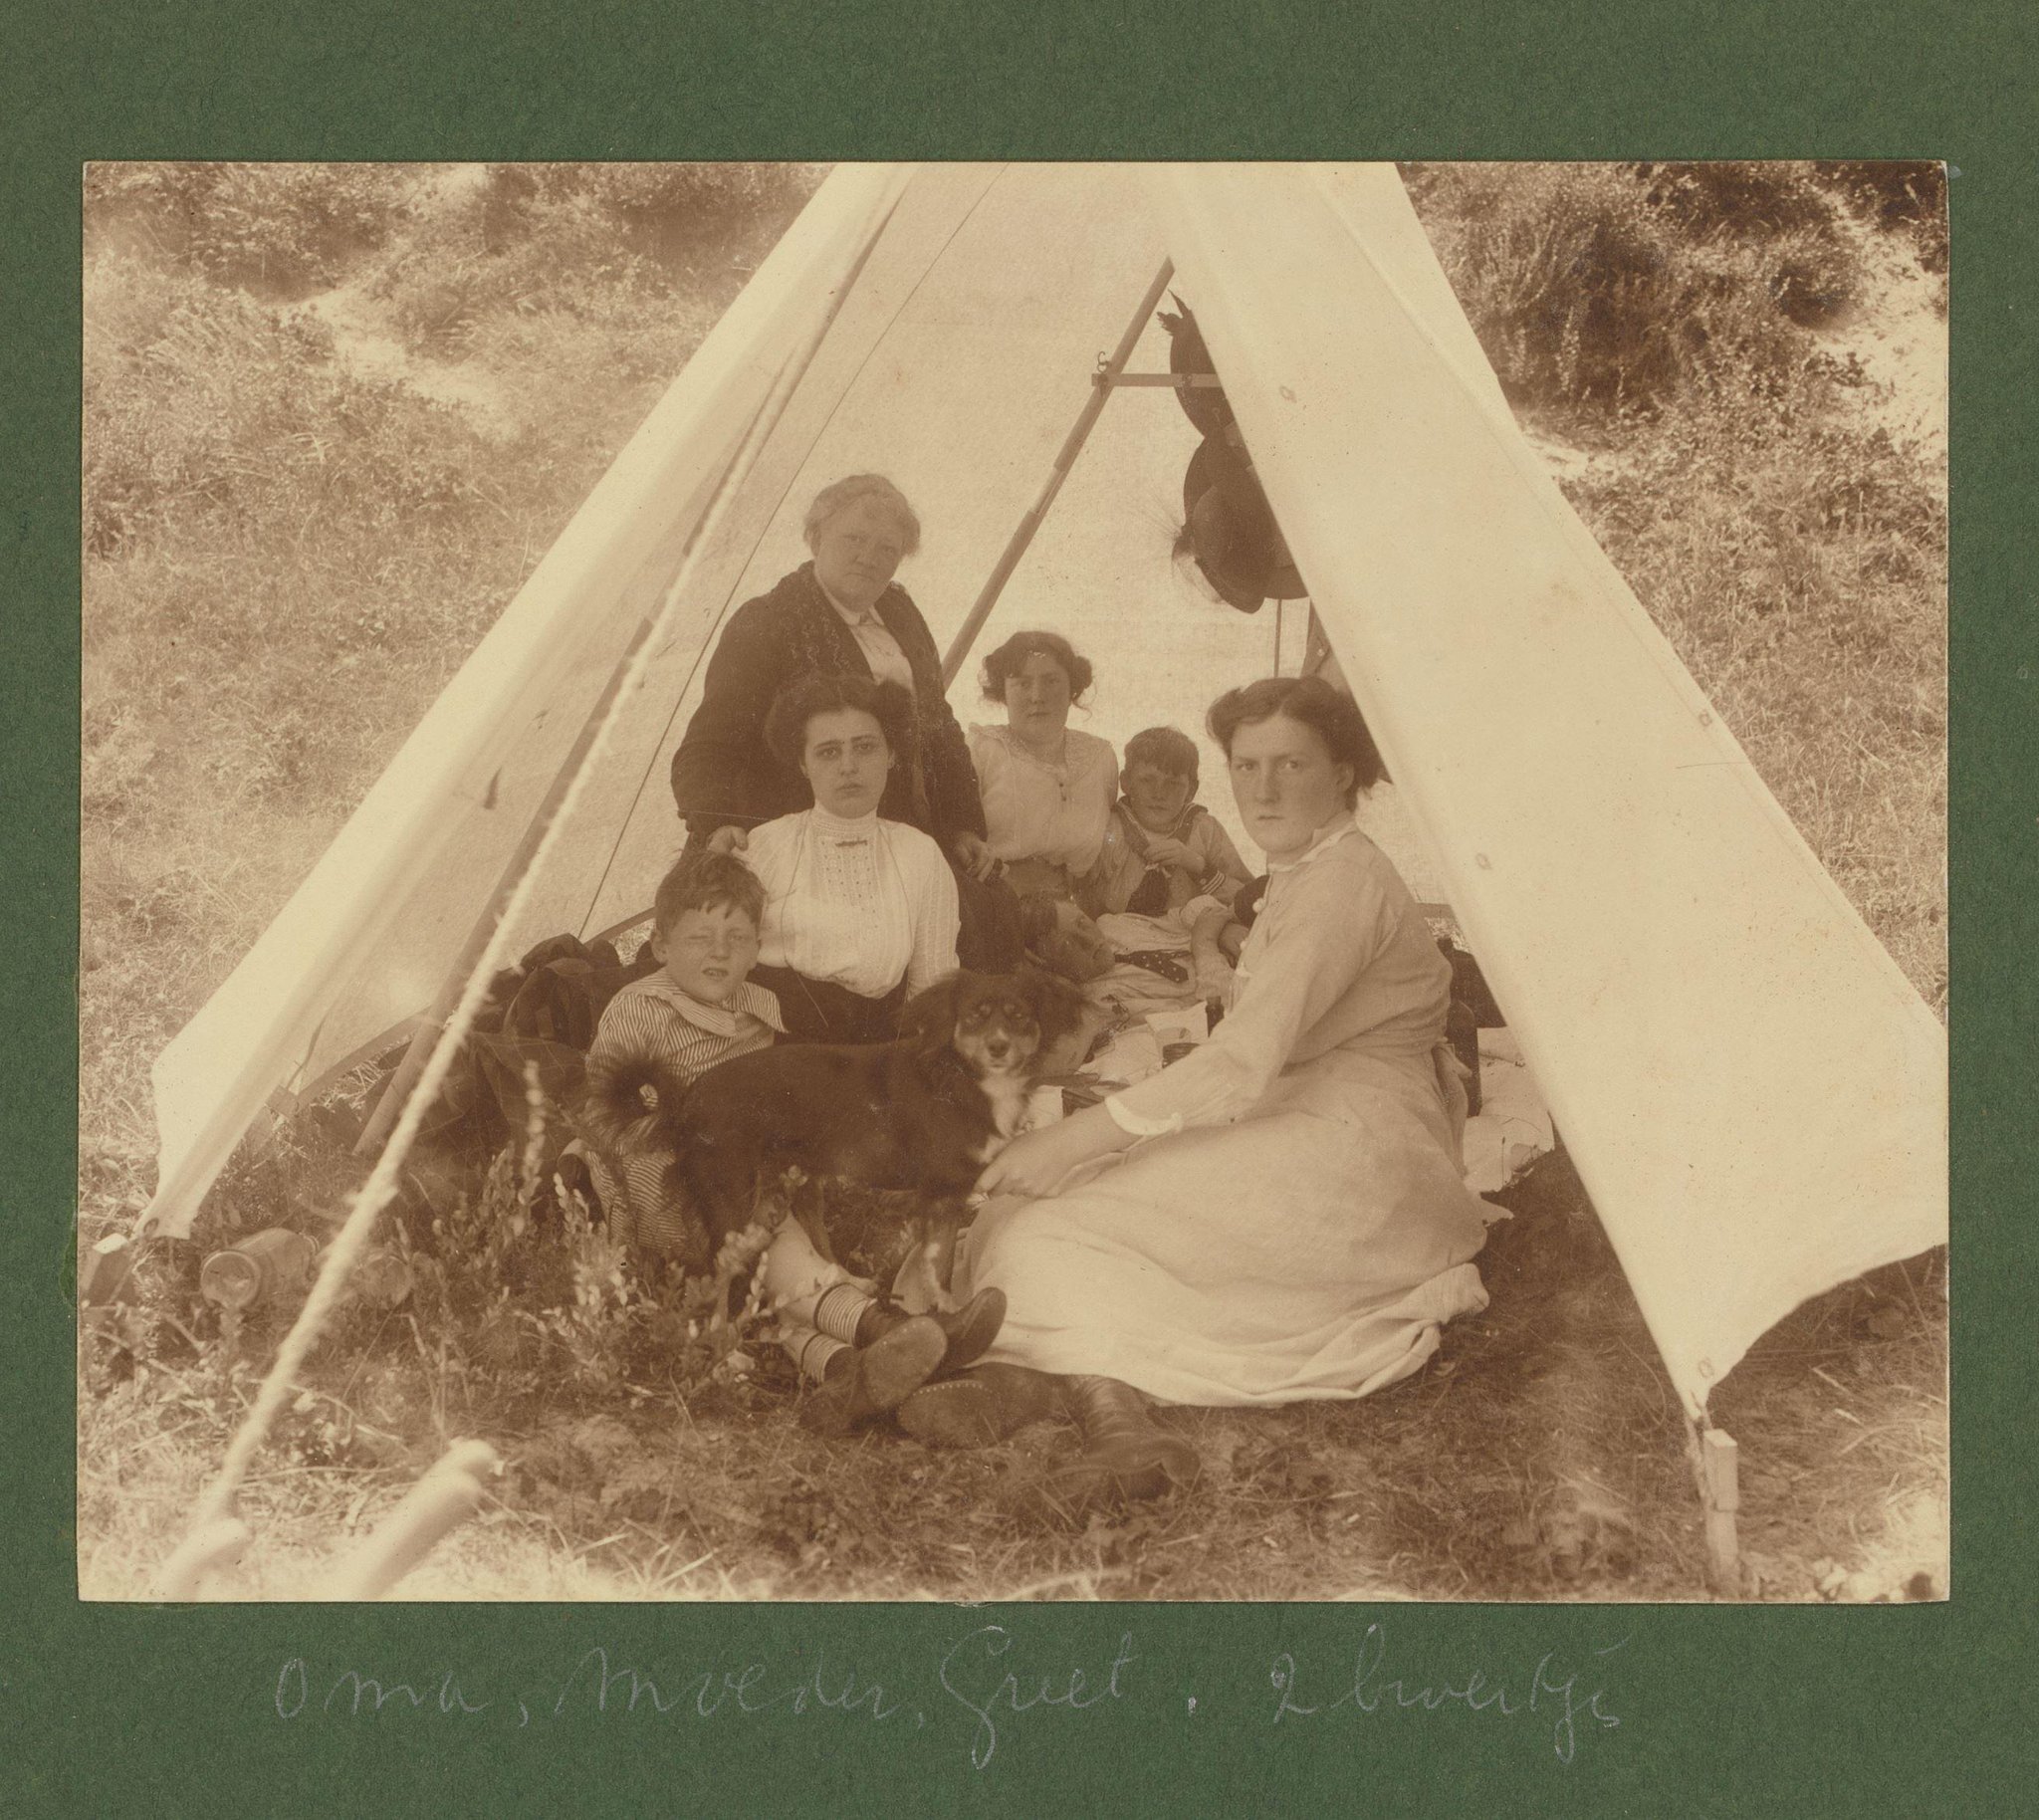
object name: album leaf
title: Groepsportret van zes leden van de familie Vermeulen en een hond in een tent in de duinen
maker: cornelis johannes lodewicus vermeulen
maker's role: fotograaf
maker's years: 1861-1936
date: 1910-1915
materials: photographic support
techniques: gelatin silver print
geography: netherlands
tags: dunes (sea not visible); in the dunes, family life, other dwelling types, dog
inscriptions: annotation: ‘Oma, moeder, Greet, 2 broertjes’